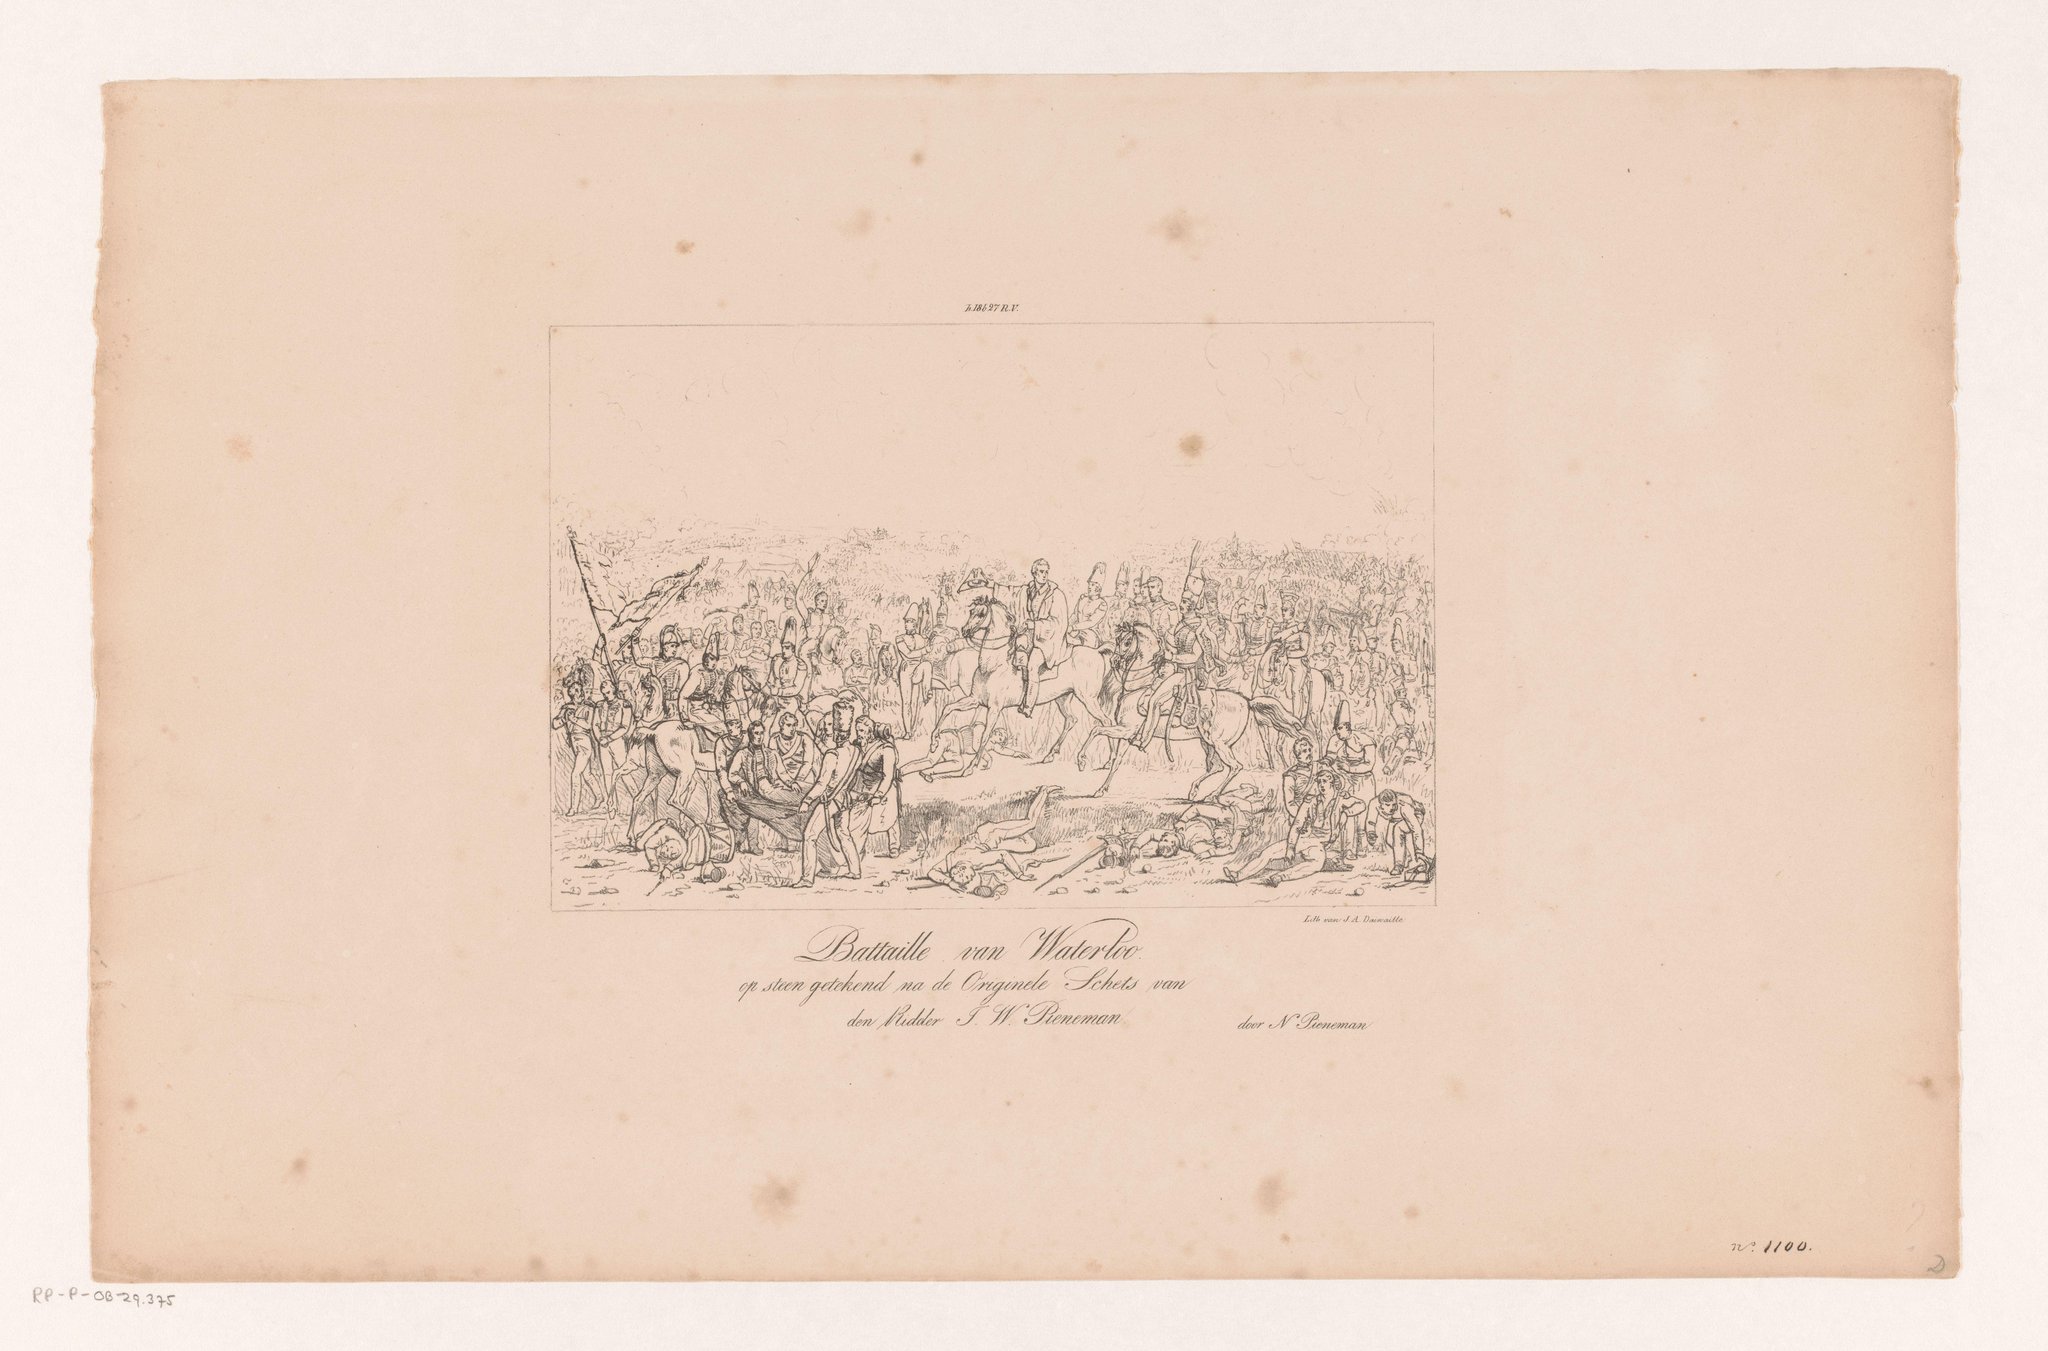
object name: print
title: Battaille van Waterloo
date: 1820-1833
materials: paper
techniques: lithograph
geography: amsterdam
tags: the hague, william ii of the netherlands, walmer castle, arthur wellesley of wellington, putting out of action by wounding, charge ~ battle, waterloo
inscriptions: collector's mark: Lugt 2228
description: De slag bij Waterloo, 18 juni 1815. Gezicht op het slagveld op het moment dat de Engelse bevelhebber Wellington hoort dat Pruisische hulp onderweg is. De gewonde Willem, prins van Oranje, wordt links op de voorgrond weggevoerd. De bevelhebbers en andere officieren te paard staan in het midden, rechts op de voorgrond gewonde en dode soldaten. Op de achtergrond woeden de gevechten op het slagveld.